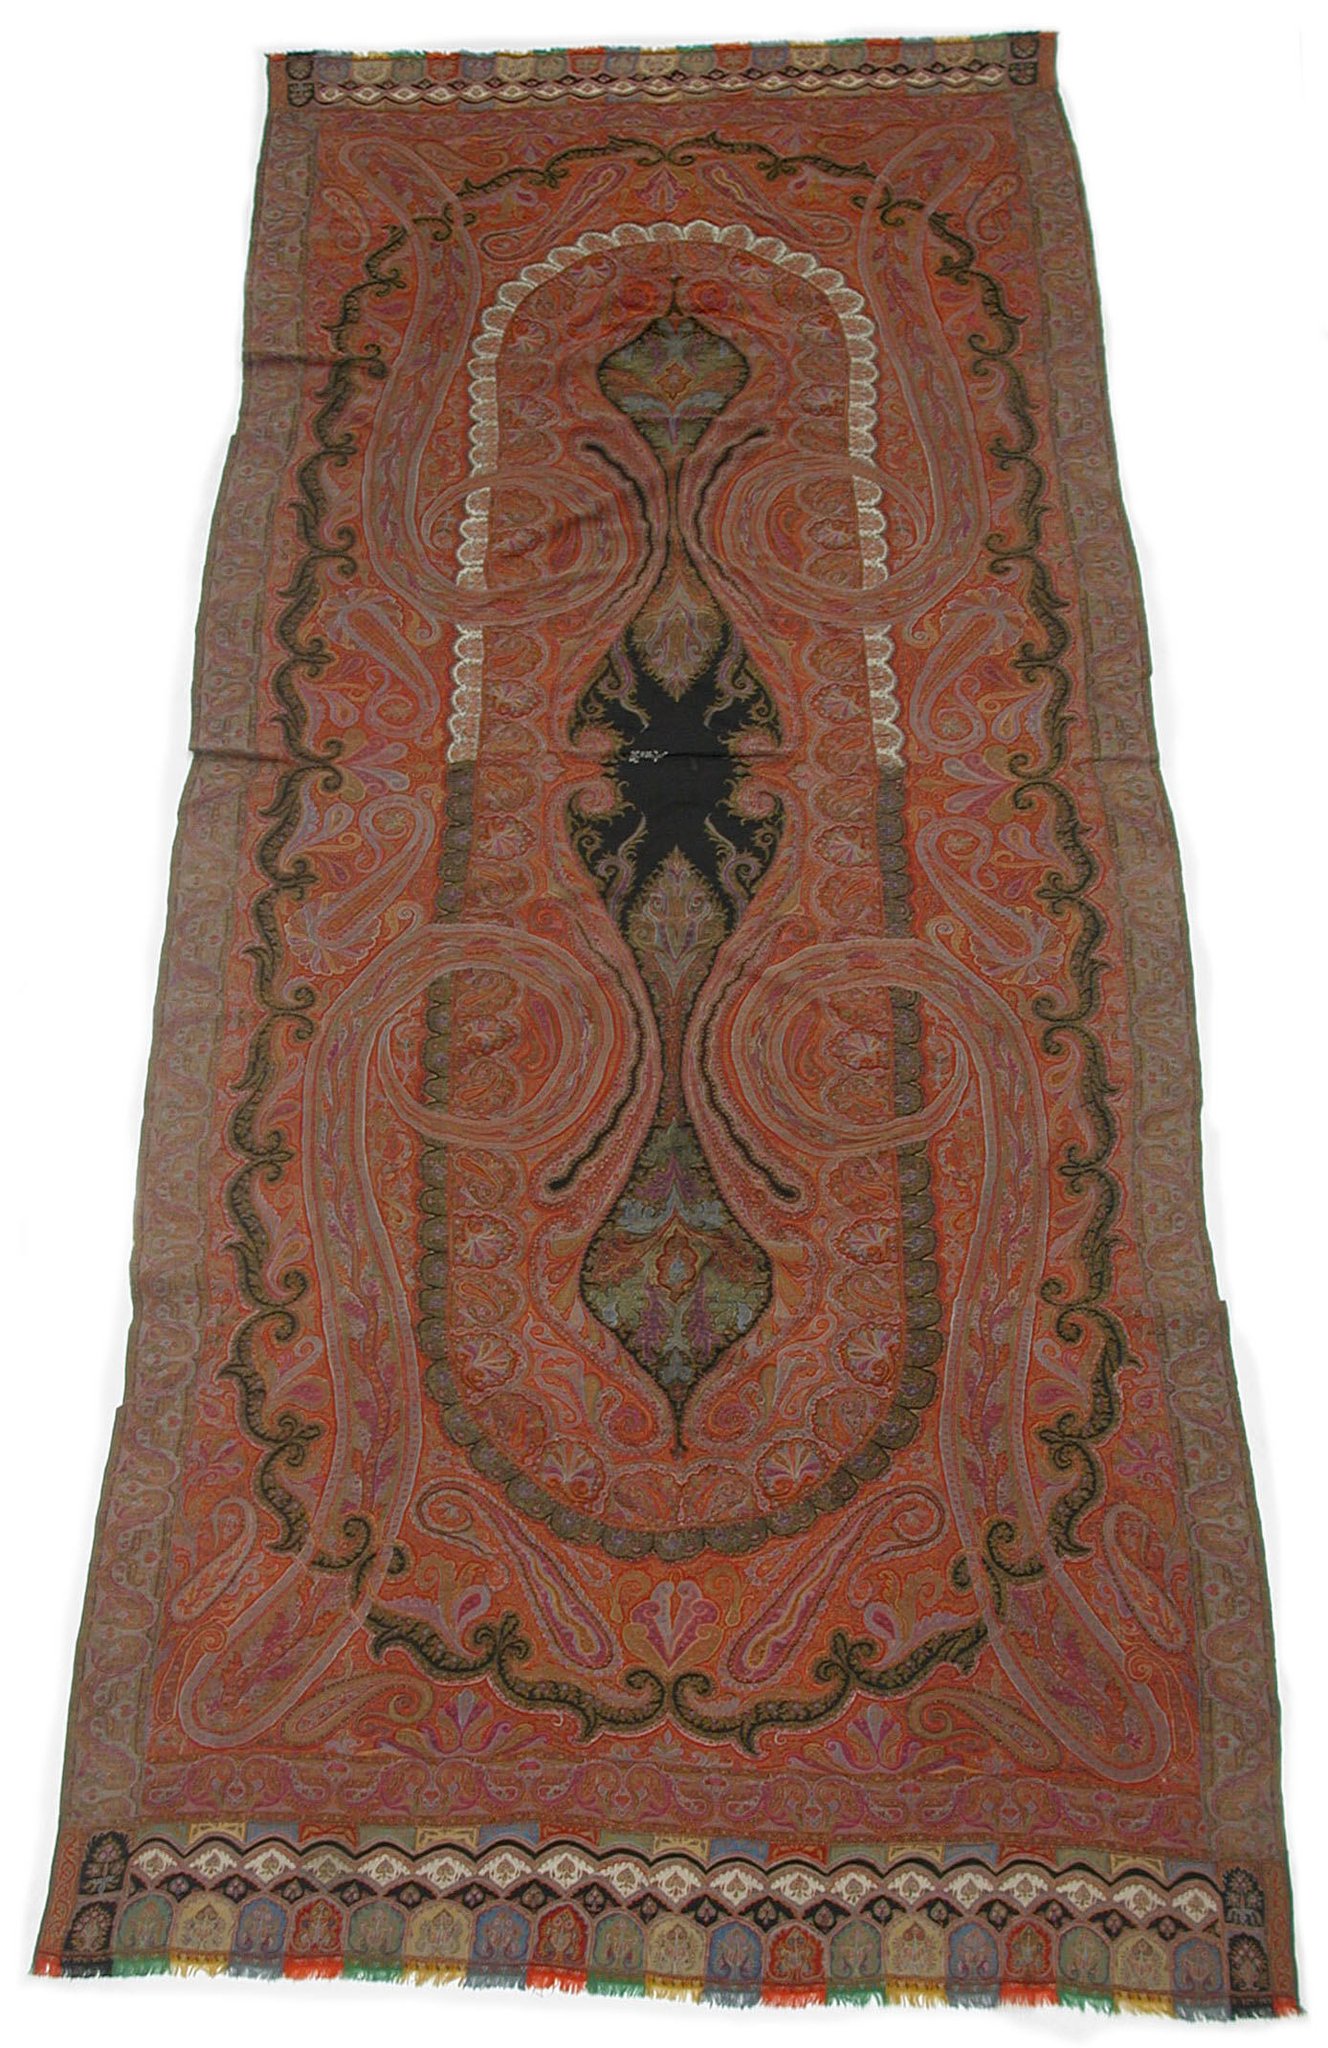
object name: shawl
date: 1834-1866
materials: wool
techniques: embroidery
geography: india